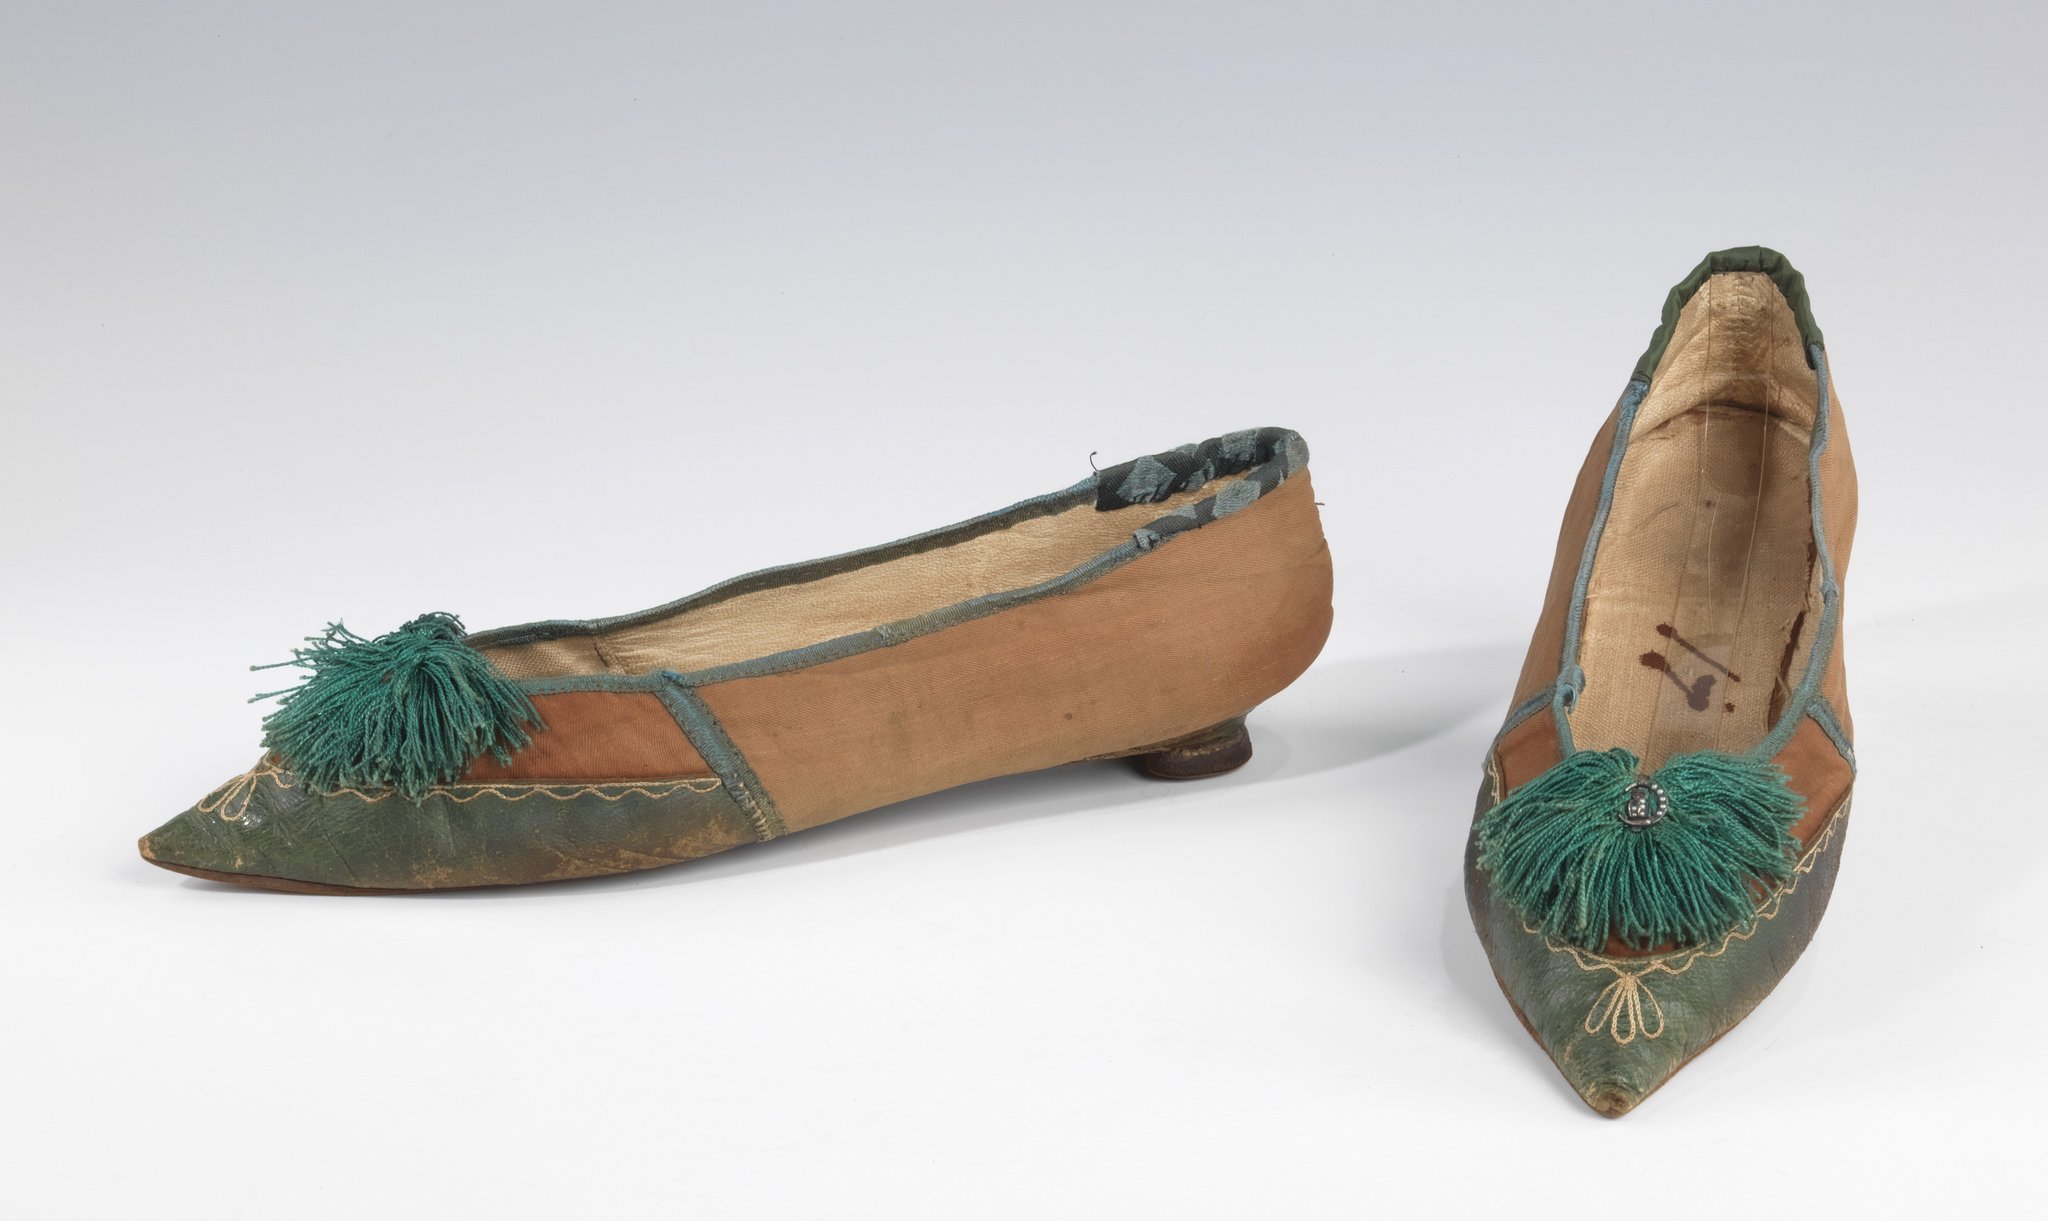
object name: slipper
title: Slippers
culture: european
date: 1805-1810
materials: cotton, leather